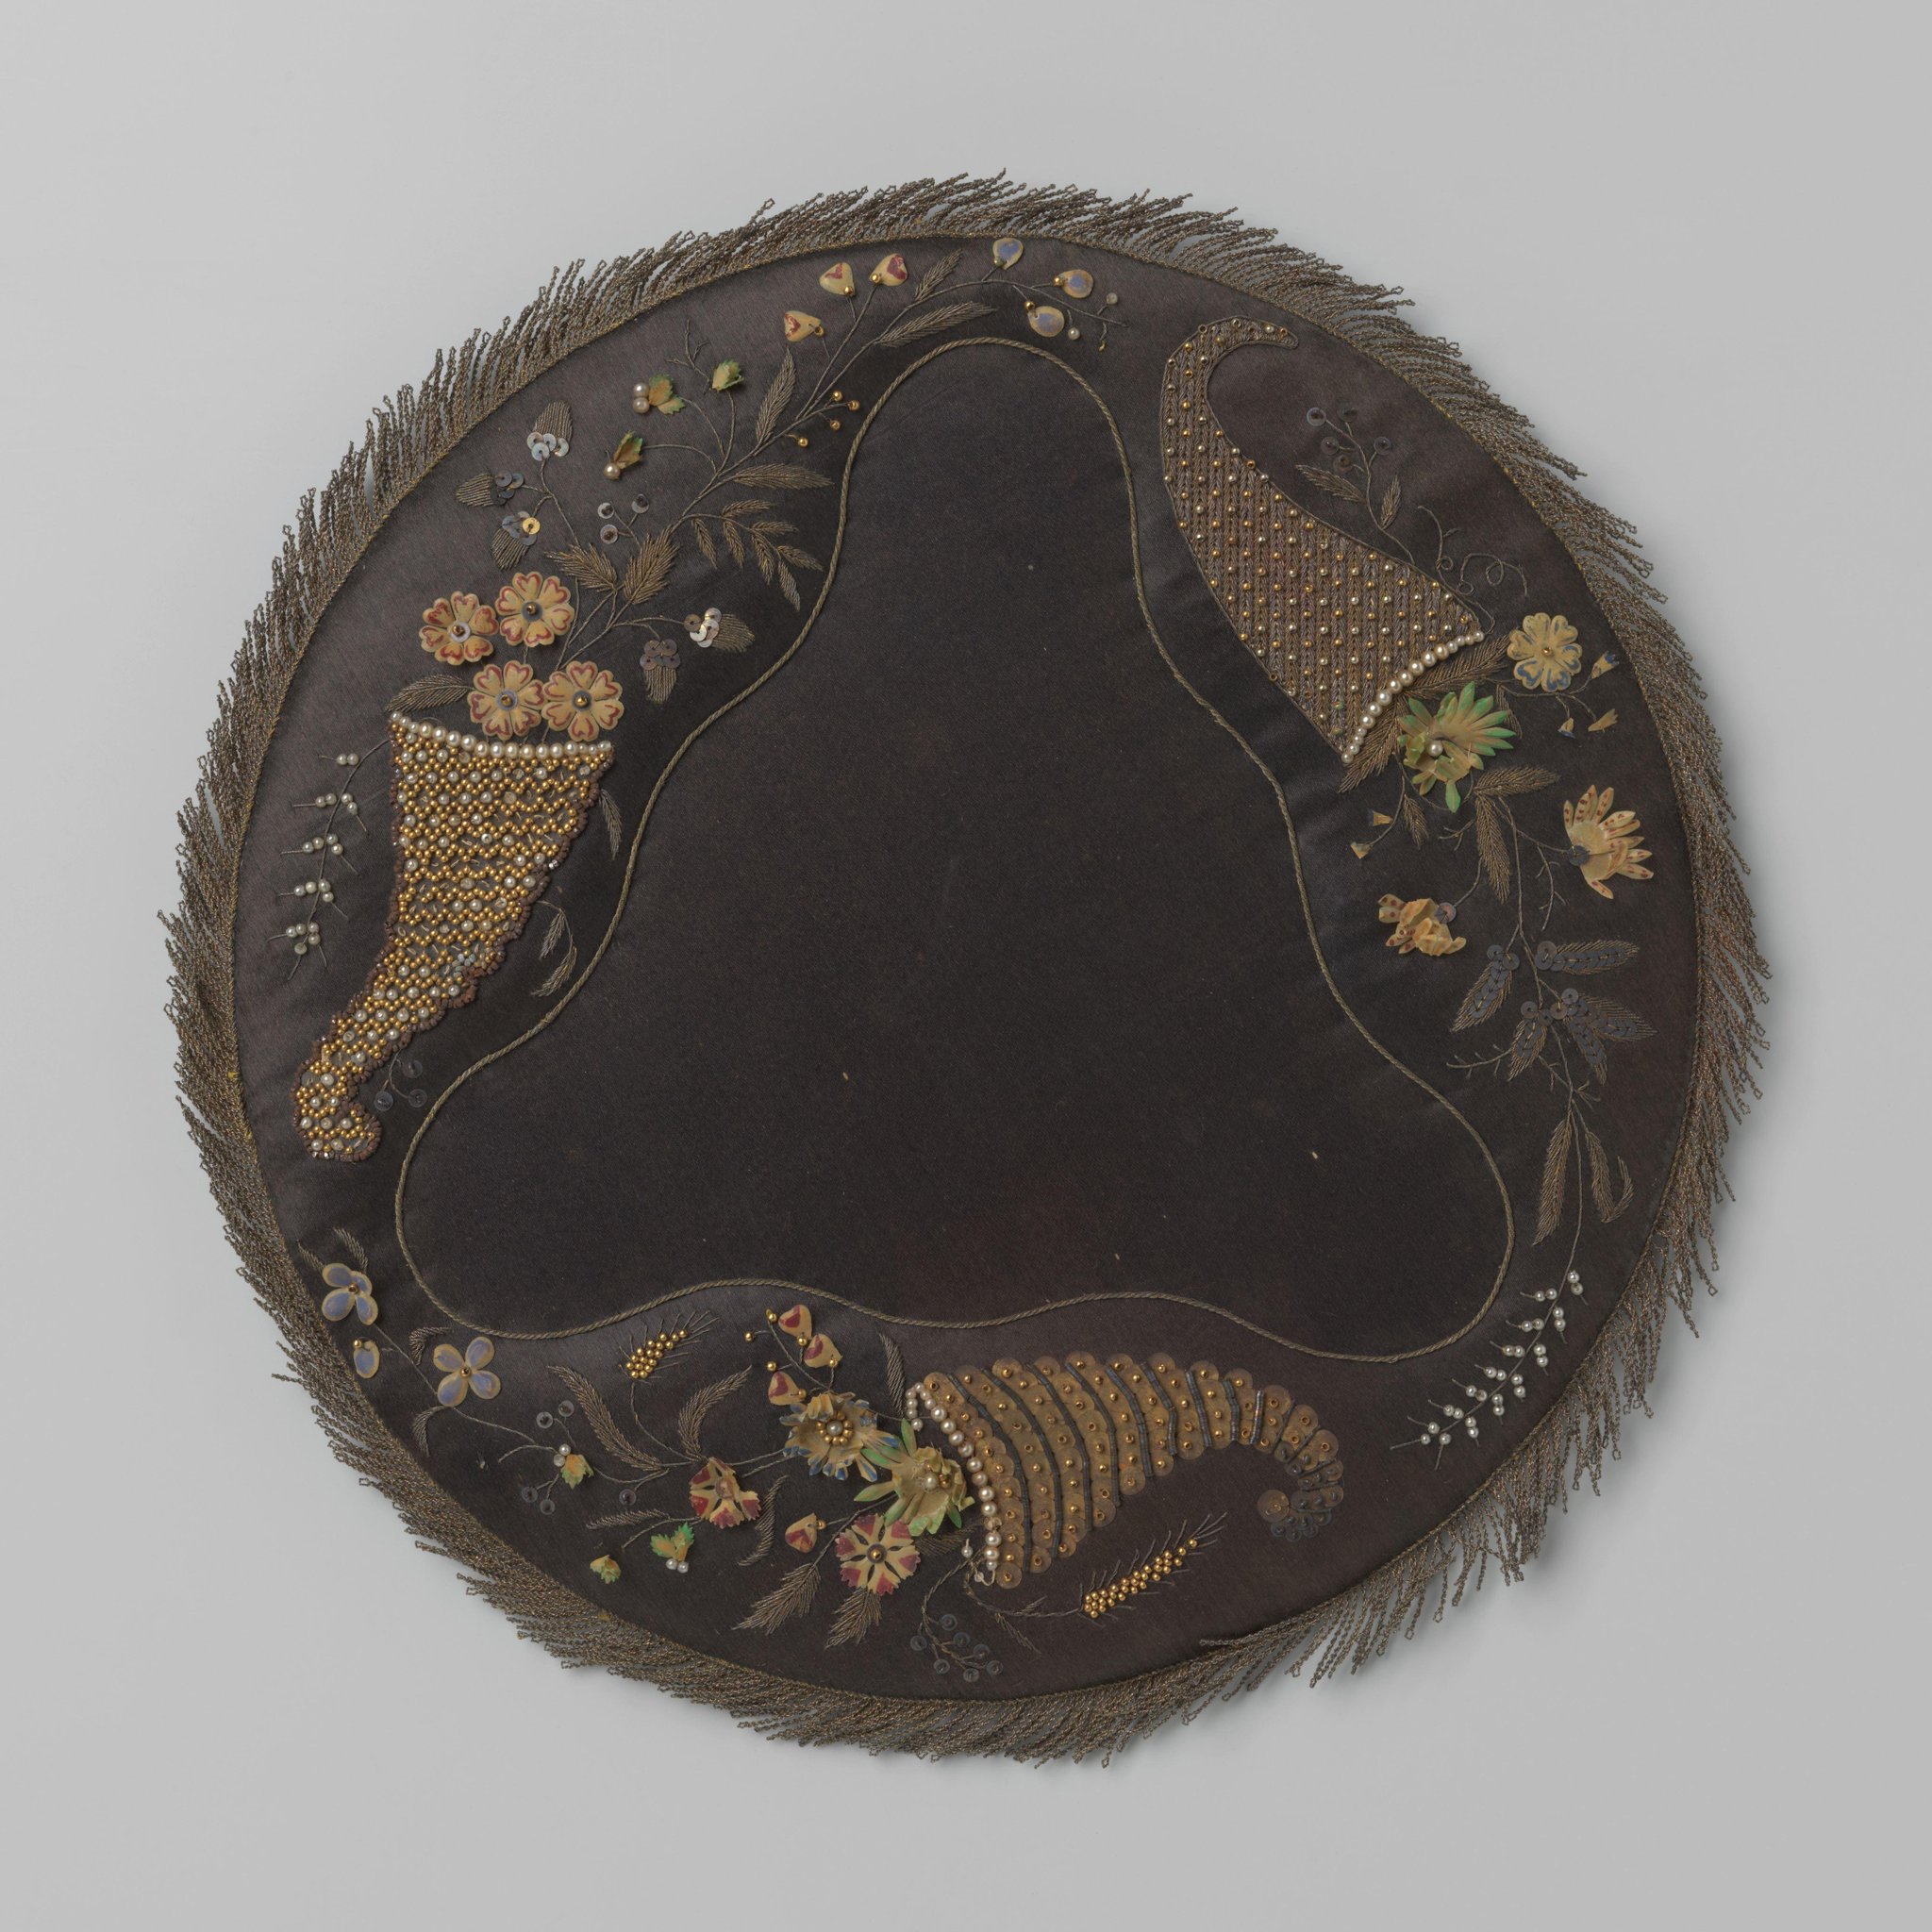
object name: lampenkleed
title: Lampenkleed van zwarte zijde, waarop geborduurd drie hoorns van overvloed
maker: Anonymous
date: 1840-1860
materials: gold thread, sequin, silk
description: Lampenkleed van zwarte zijde, waarop geborduurd drie hoorns van overvloed, waaruit bloemen en vruchten komen. Met gouddraad, pailletten en kralen.